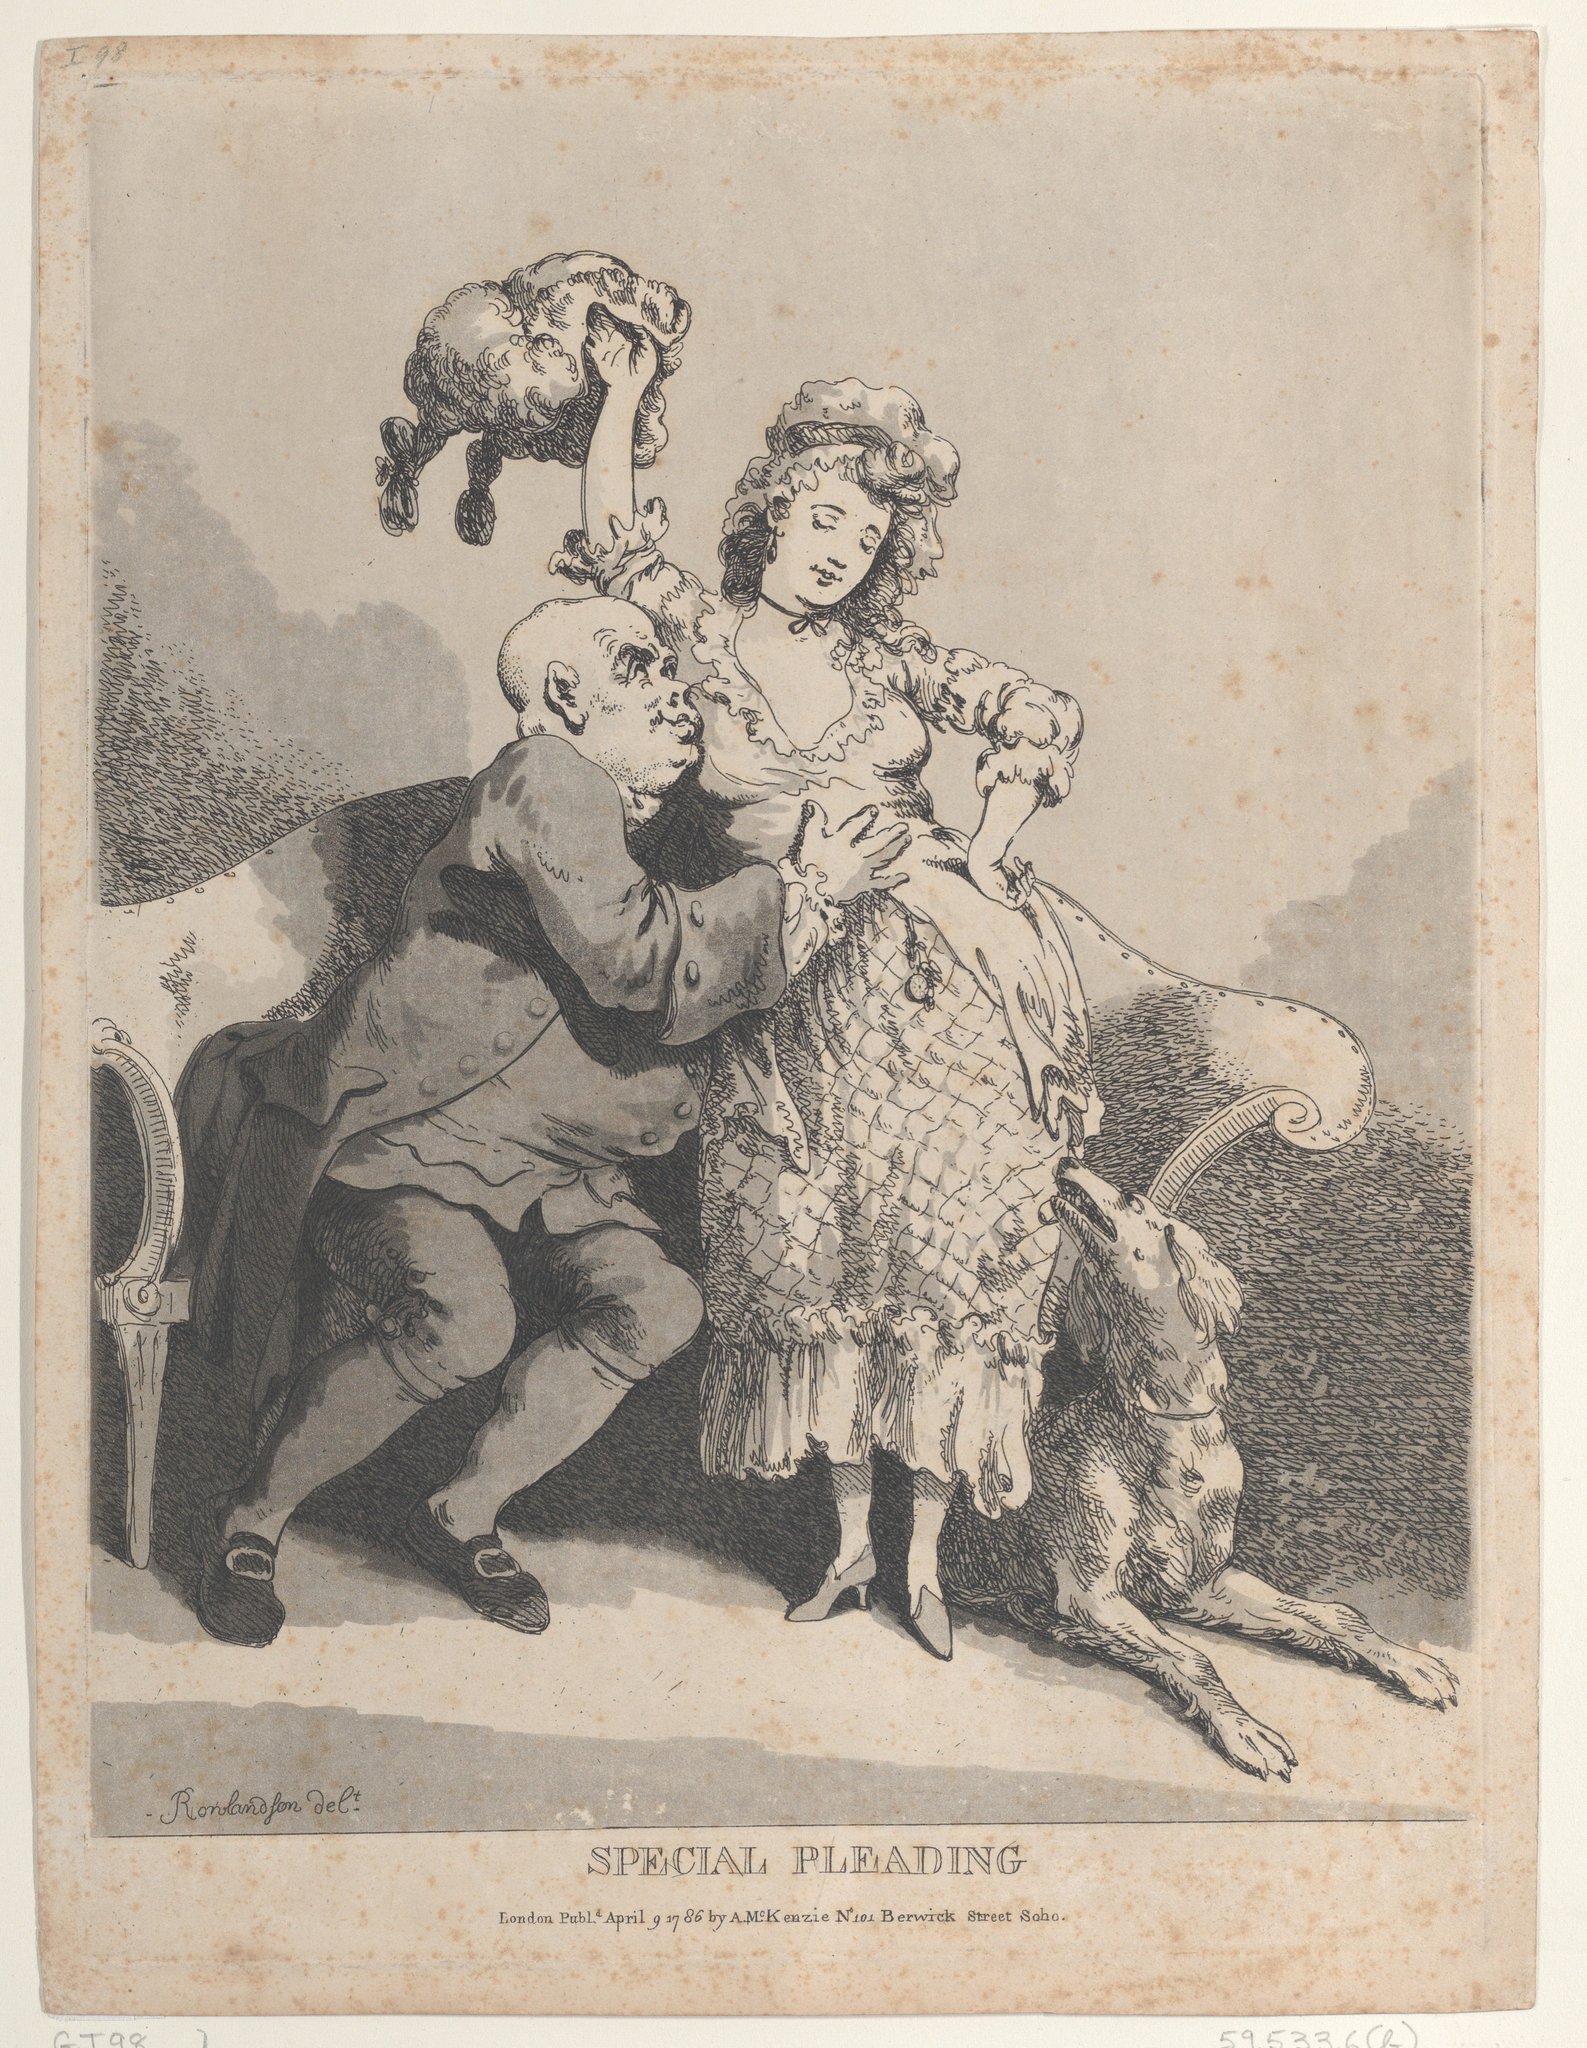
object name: print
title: Special Pleading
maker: thomas rowlandson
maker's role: artist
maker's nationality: british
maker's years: 1757-1827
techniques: aquatint, etching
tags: satire,men,women,dogs